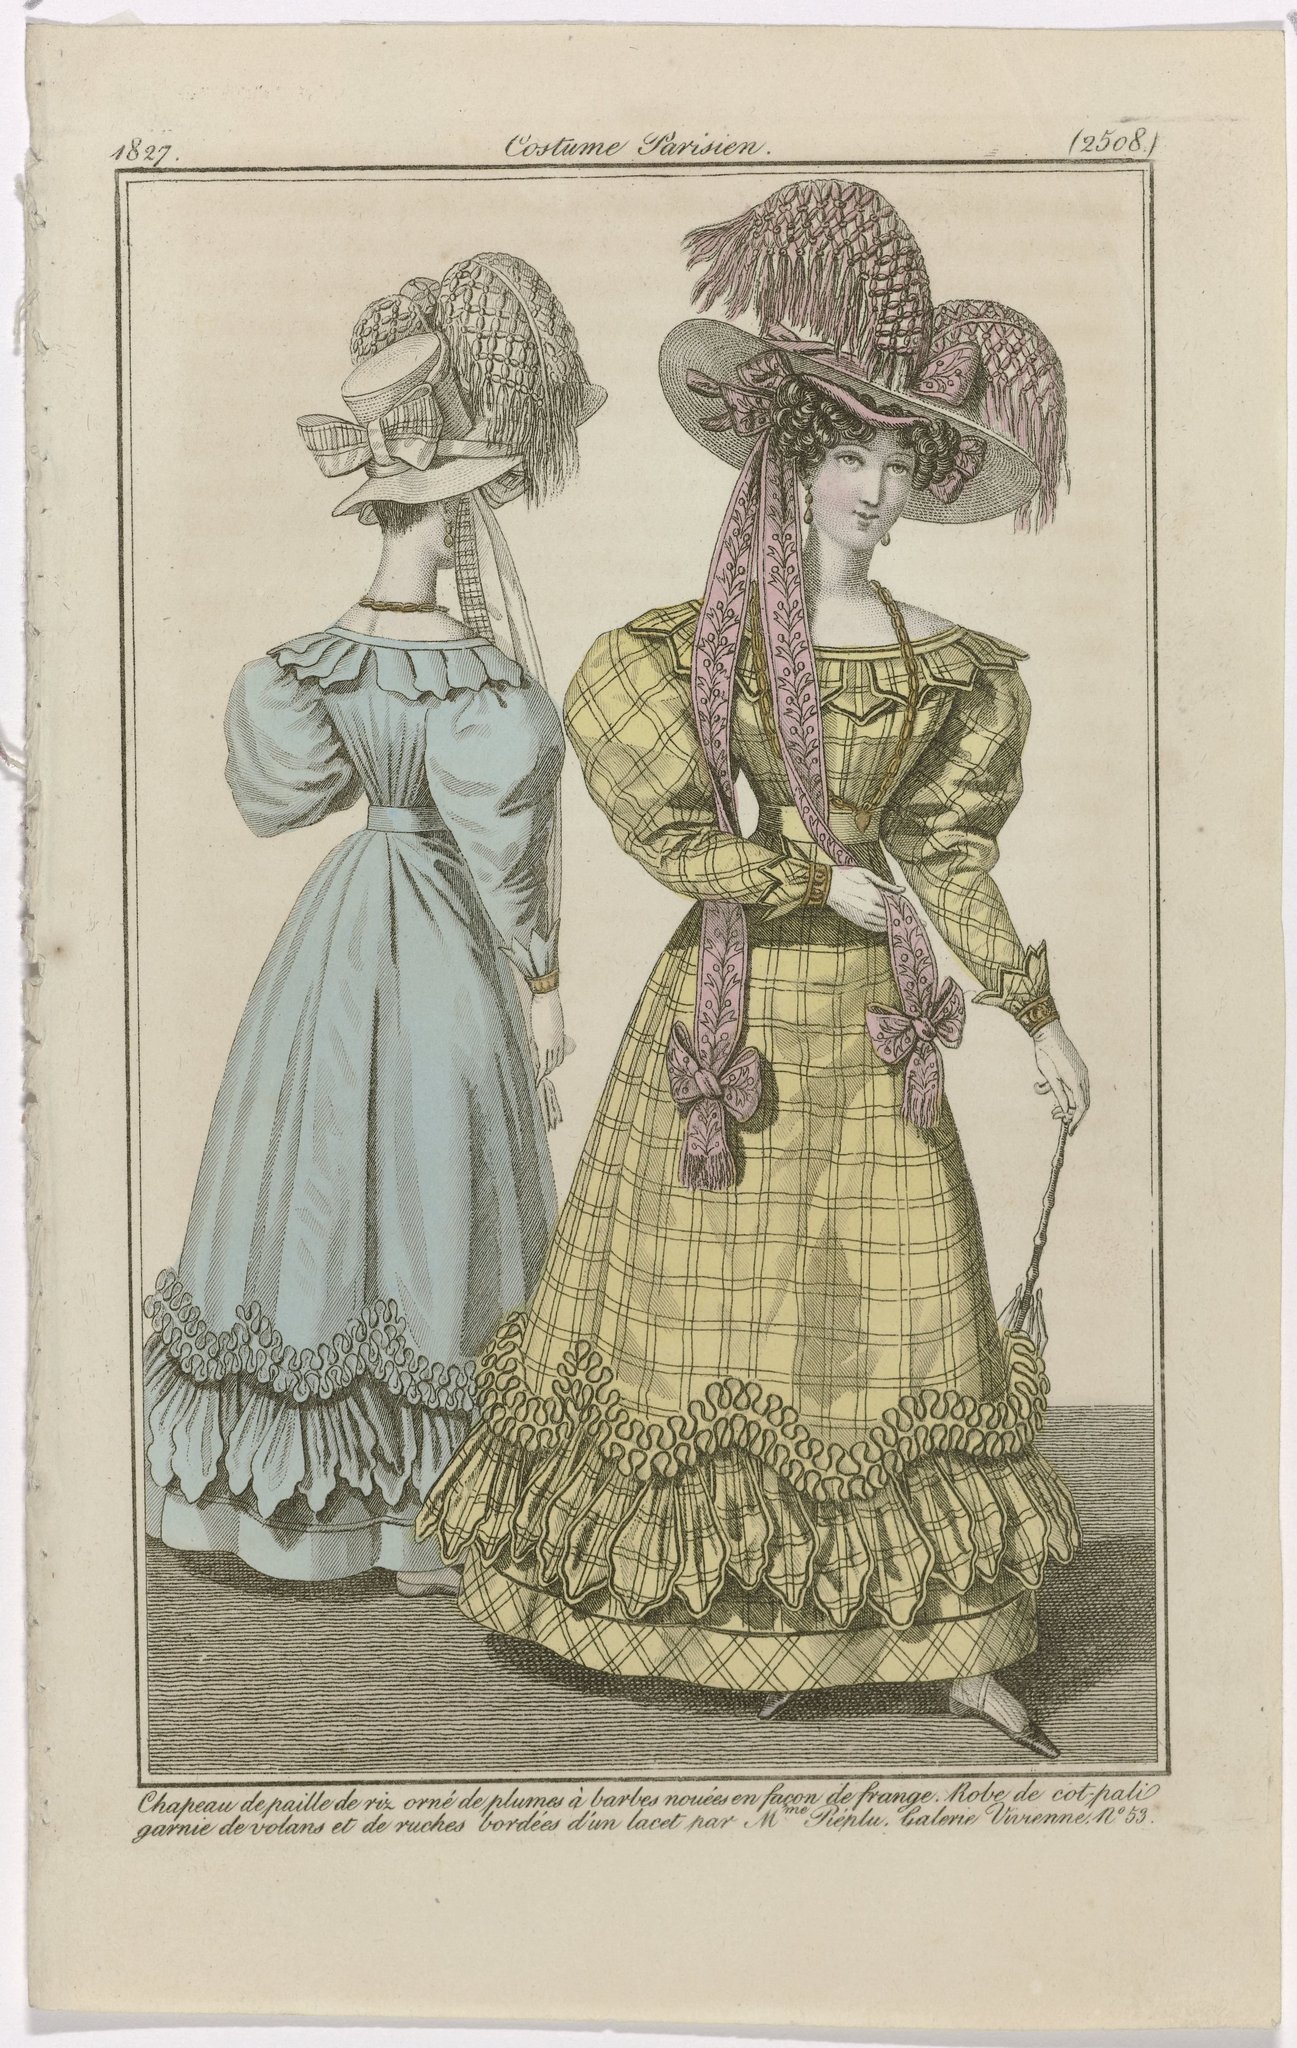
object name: fashion print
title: Journal des Dames et des Modes, Costume Parisien, 5 juin 1827, (2508): Chapeaux de paill (...)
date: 1827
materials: paper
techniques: engraving, hand coloring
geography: paris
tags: ear-rings (+ women's clothes), ornamental parts of clothing (+ women's clothes), head-gear (+ women's clothes), fashion plates, shoes, sandals (+ women's clothes), gloves, mittens, etc. (+ women's clothes), dress, gown (+ women's clothes), bracelet, wristlet (+ women's clothes), necklace (+ women's clothes), parasol, sunshade (+ women's clothes)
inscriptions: caption: ‘Chapeau de paille de riz orné de plumes à barbes nouées en façon de frange. Robe de cot-pali garnie de volans et de ruches bordées d'un lacet par Mme. Piéplu, Galerie Vivienne, No. 53.’, title: ‘Costume Parisien.’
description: Twee vrouwen, van wie één op de rug gezien, gekleed in japonnen van 'cot-pali' versierd met volants en ruches afgezet met een 'lacet' van Piéplu. Hoeden van 'paille de riz' versierd met veren en gestrikte slippen met aan de uiteinden franjes. Verdere accessoires: oorbellen, collier met hanger, armbanden om beide polsen, handschoenen, parasol, platte schoenen. De prent maakt deel uit van het modetijdschrift Journal des Dames et des Modes, uitgegeven door Pierre de la Mésangère, Parijs, 1797-1839.